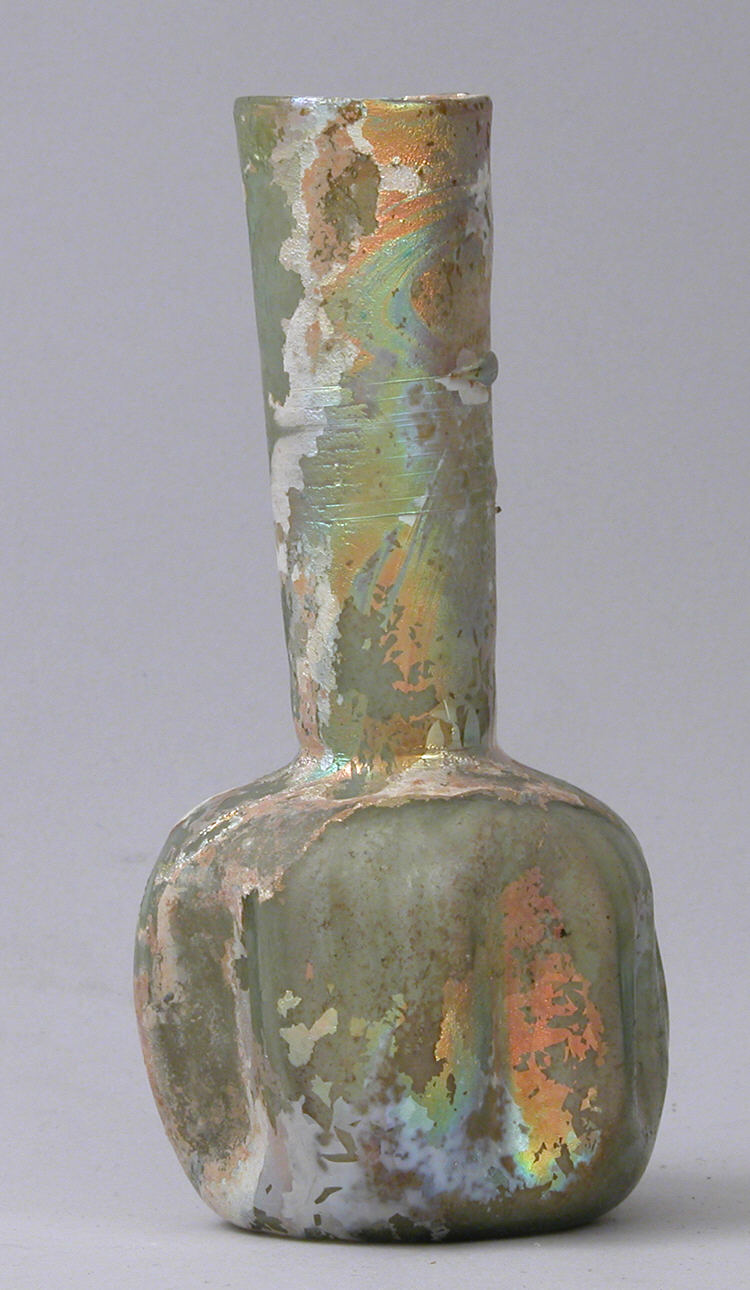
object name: bottle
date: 401-600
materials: glass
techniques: glassblowing, tooling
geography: syria